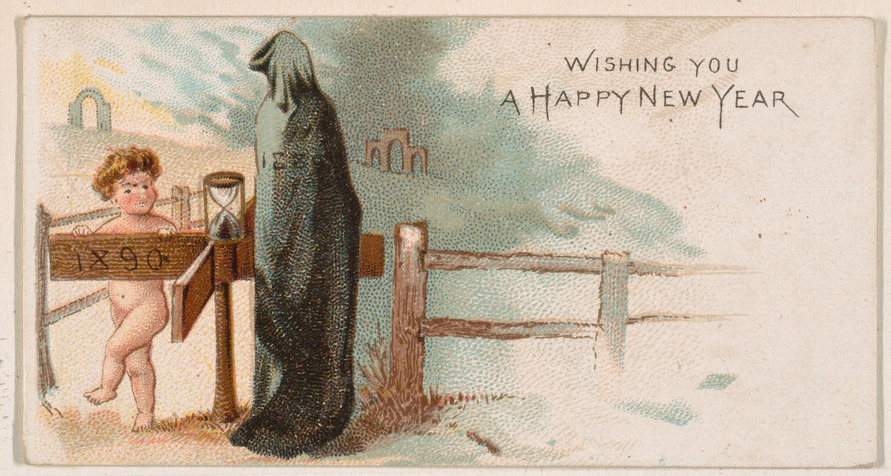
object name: print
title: Wishing You a Happy New Year, from the New Years 1890 series (N227) issued by Kinney Bros.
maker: kinney brothers tobacco company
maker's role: publisher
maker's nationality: american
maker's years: 1869-2011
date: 1889-1890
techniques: color lithograph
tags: children